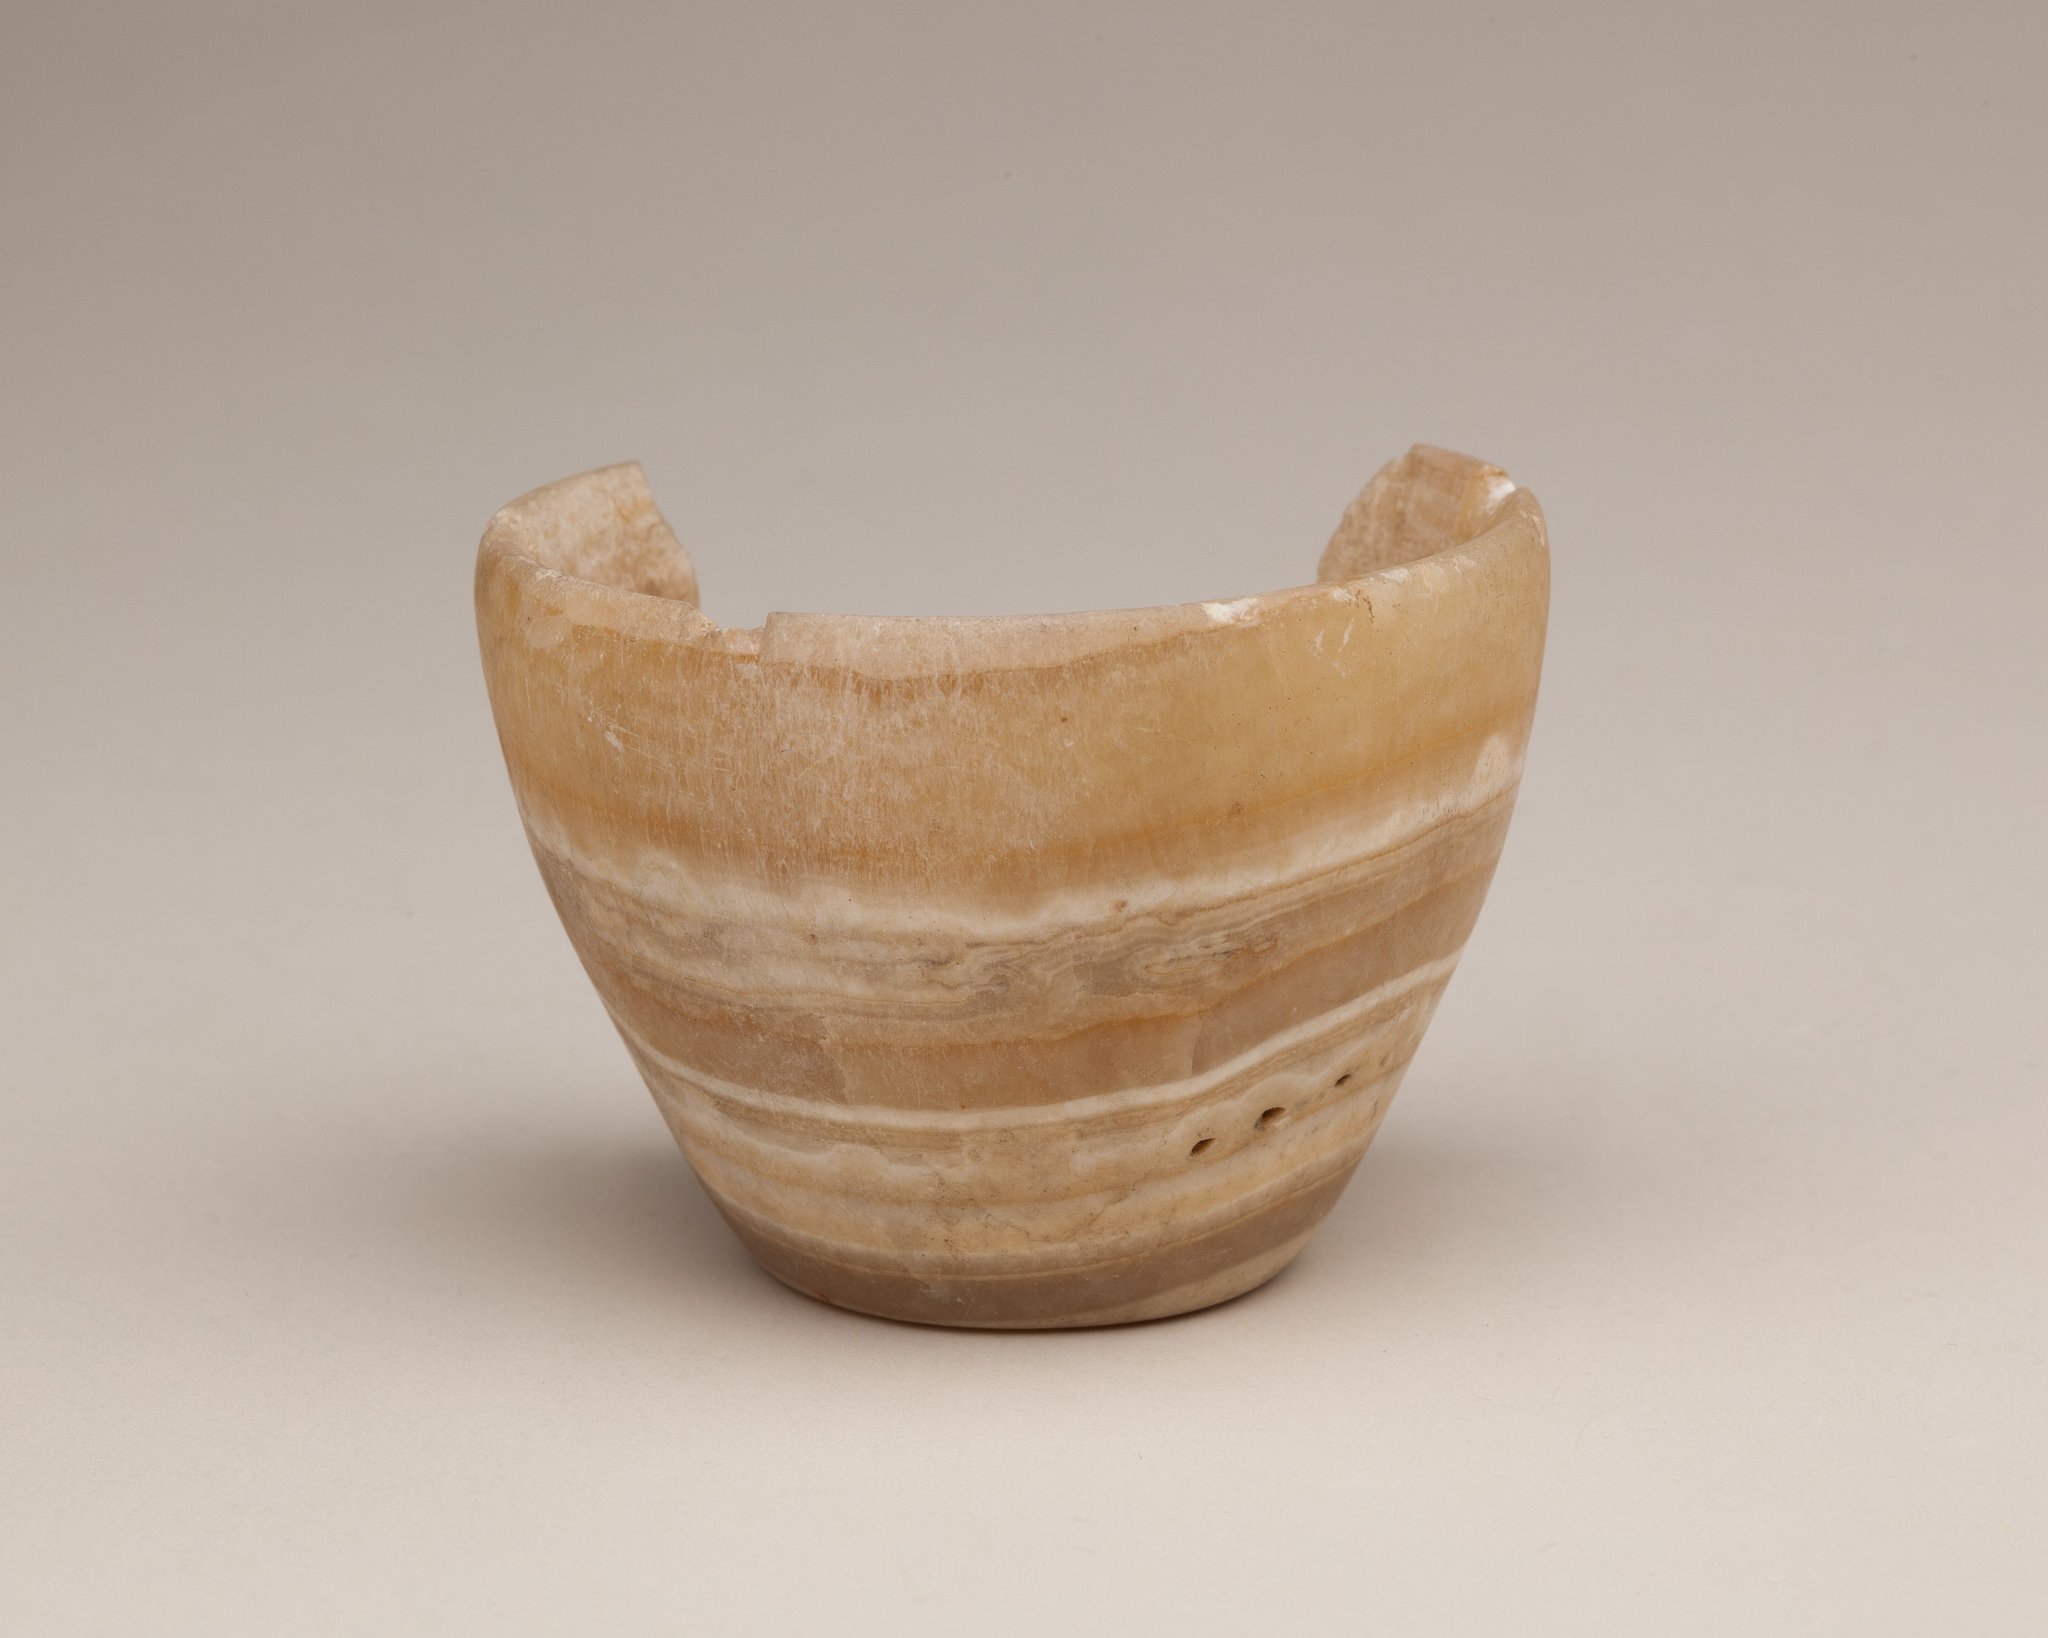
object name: bowl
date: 1981-1640 BCE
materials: stone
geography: egypt